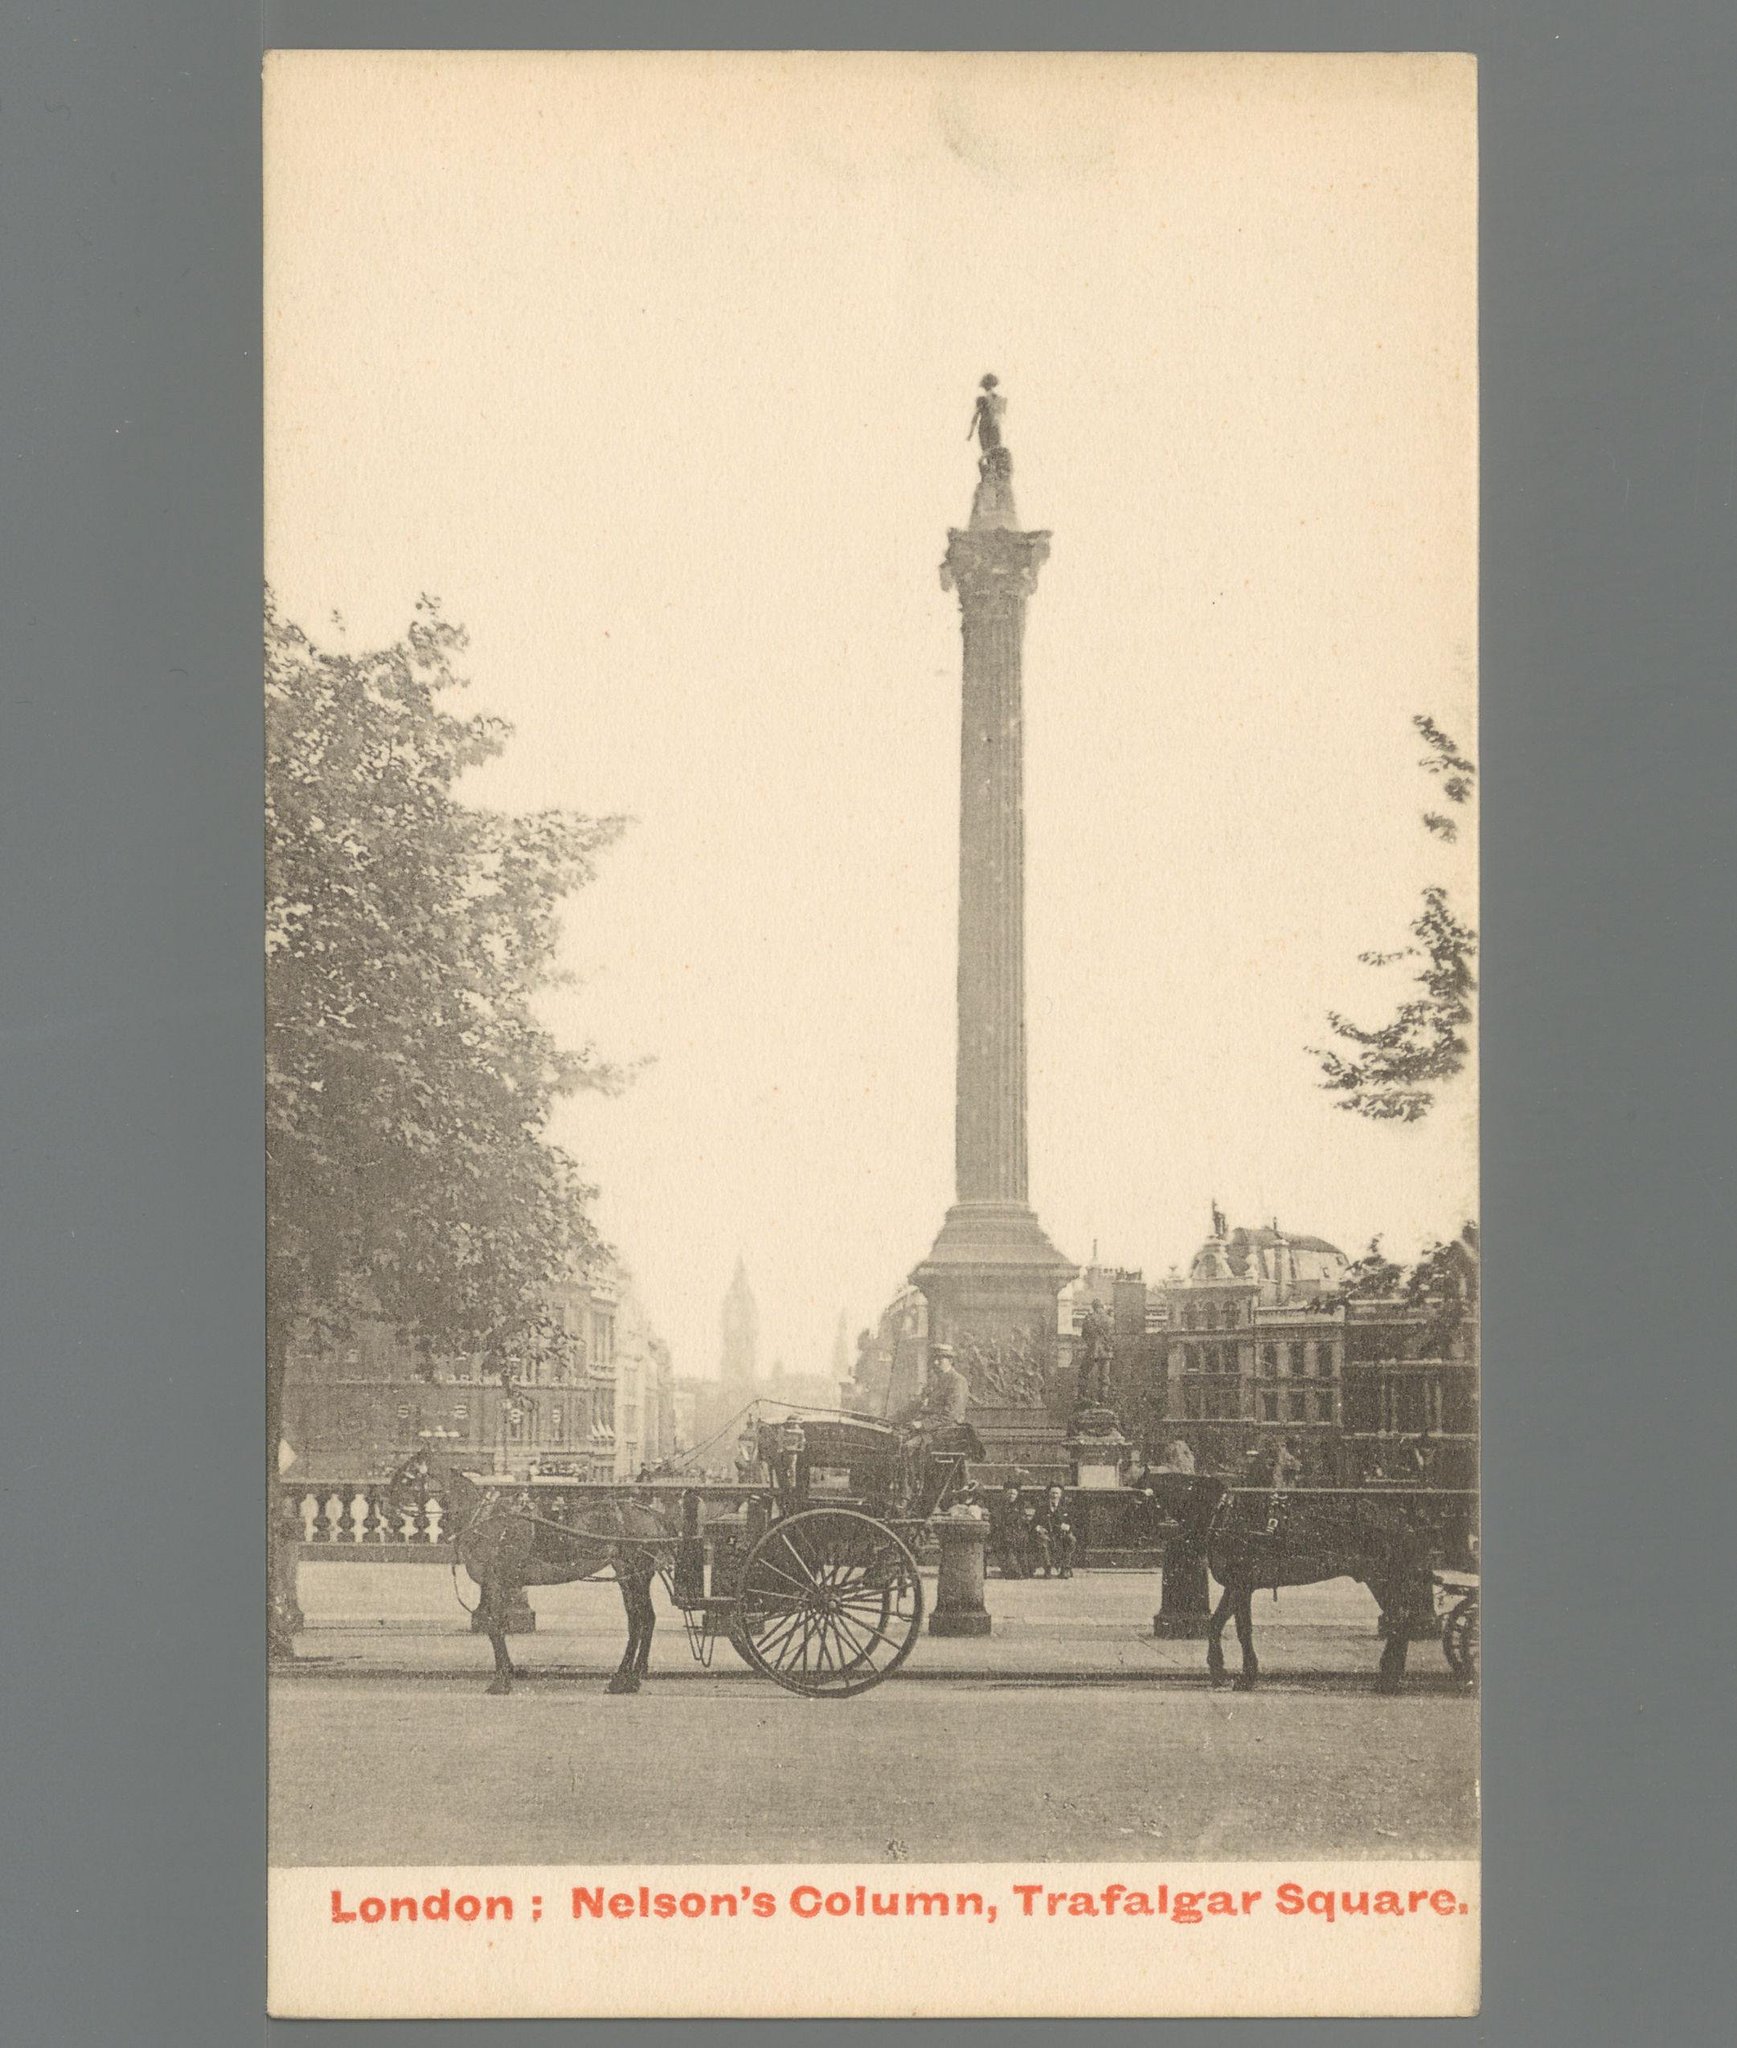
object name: photomechanical print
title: London; Nelson's Column, Trafalgar Square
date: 1902-1918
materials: cardboard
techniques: photograph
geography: london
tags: horatio nelson (hertog van bronte), square, place, circus, etc., monument, statue